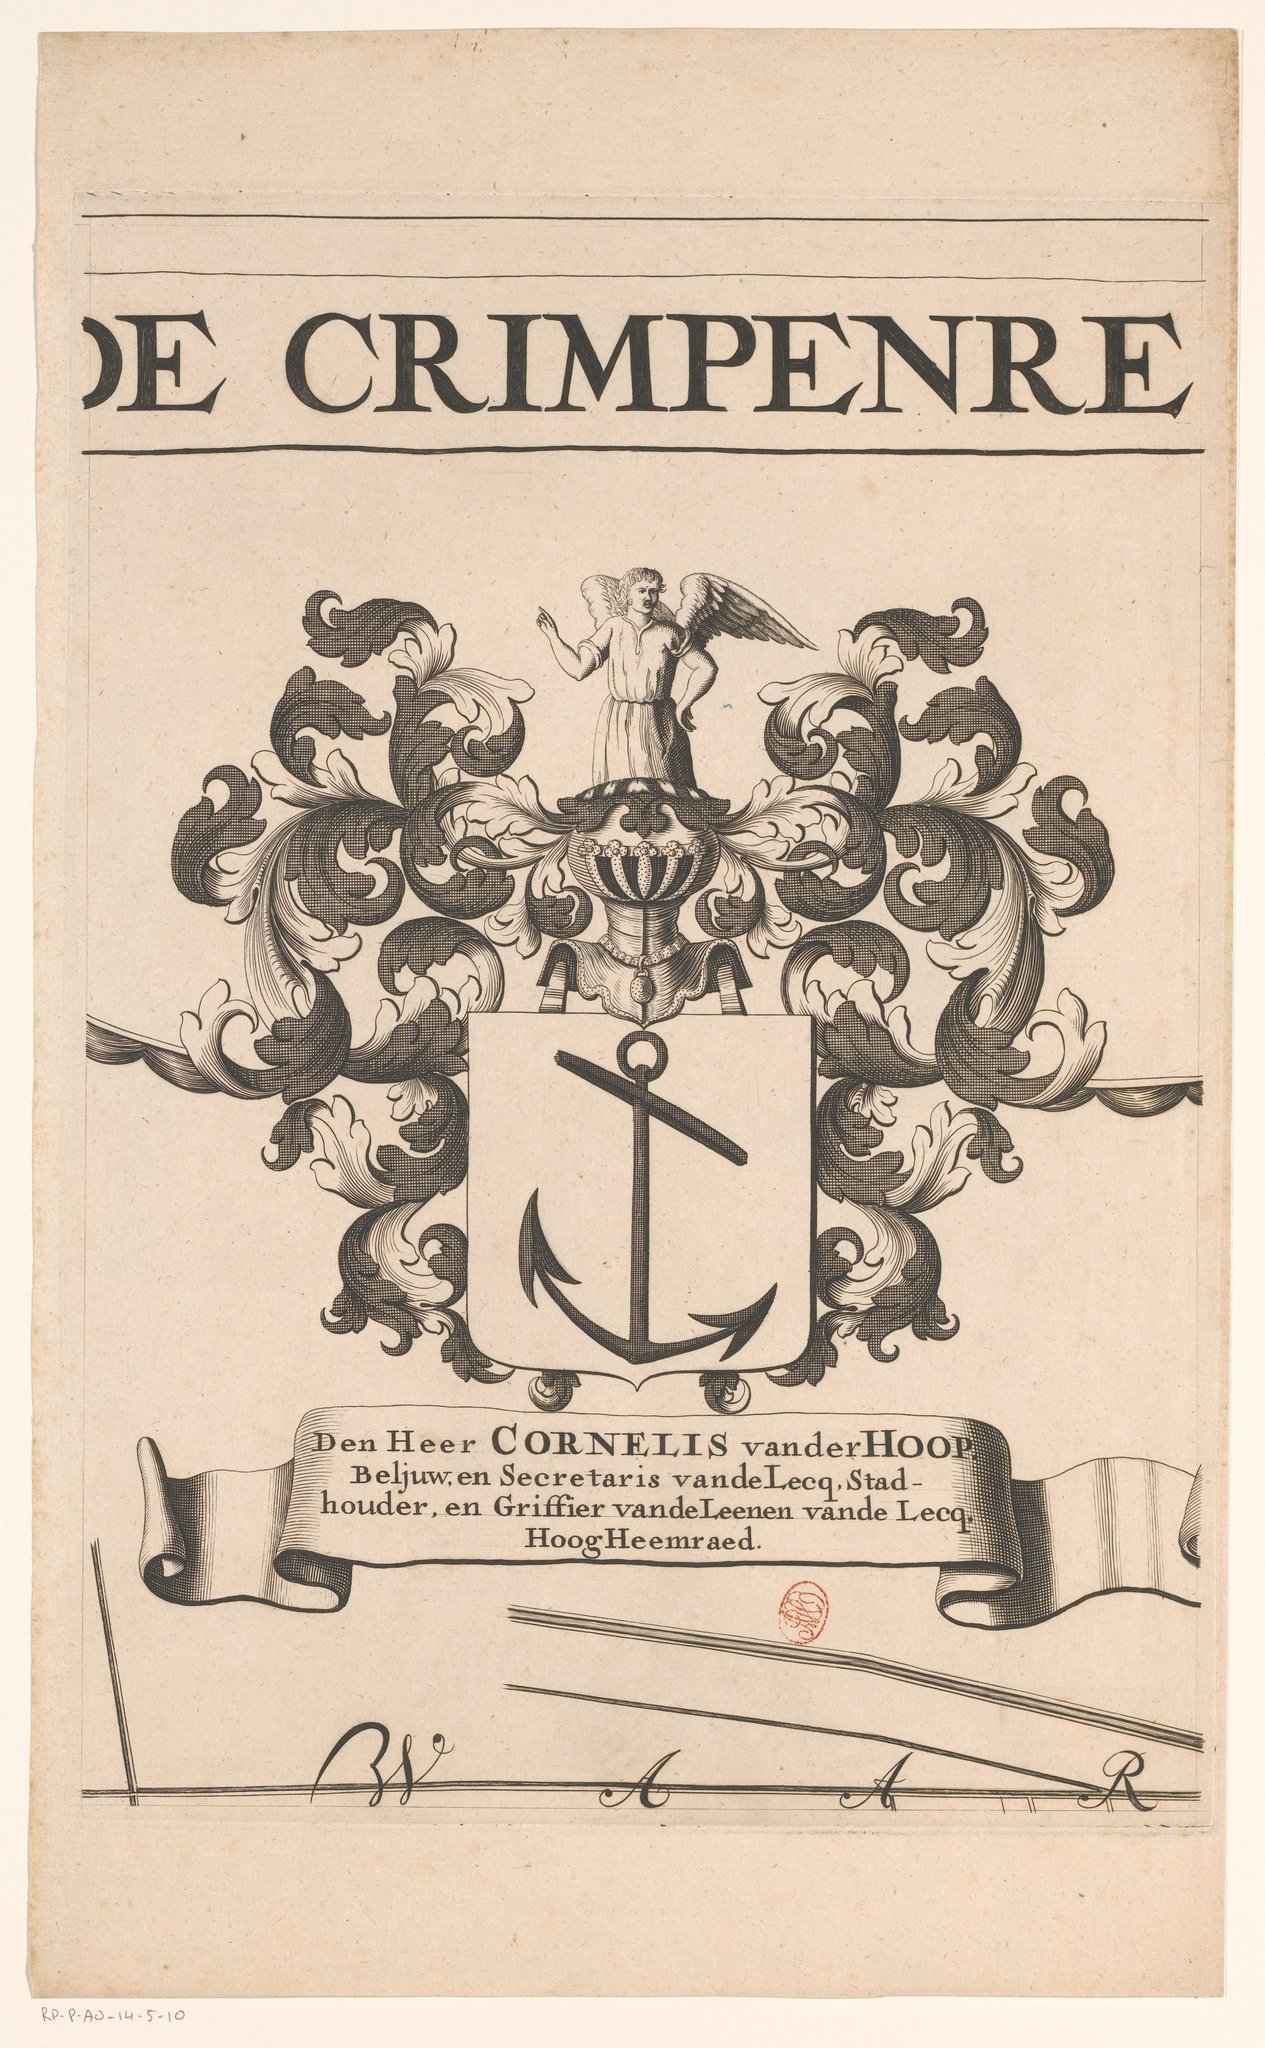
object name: print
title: Het Hooge Heemraadschap vande Crimpenre Waard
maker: Anonymous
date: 1683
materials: paper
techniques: engraving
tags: maps of separate countries or regions, armorial bearing, heraldry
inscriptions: collector's mark: Lugt 195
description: Deel van de wapenrand van de derde druk van 'Het Hooge Heemraadschap vande Crimpenre Waard', een wandkaart (bestaande uit een kaart en een wapenrand) van het Hoogheemraadschap van de Krimpenerwaard.